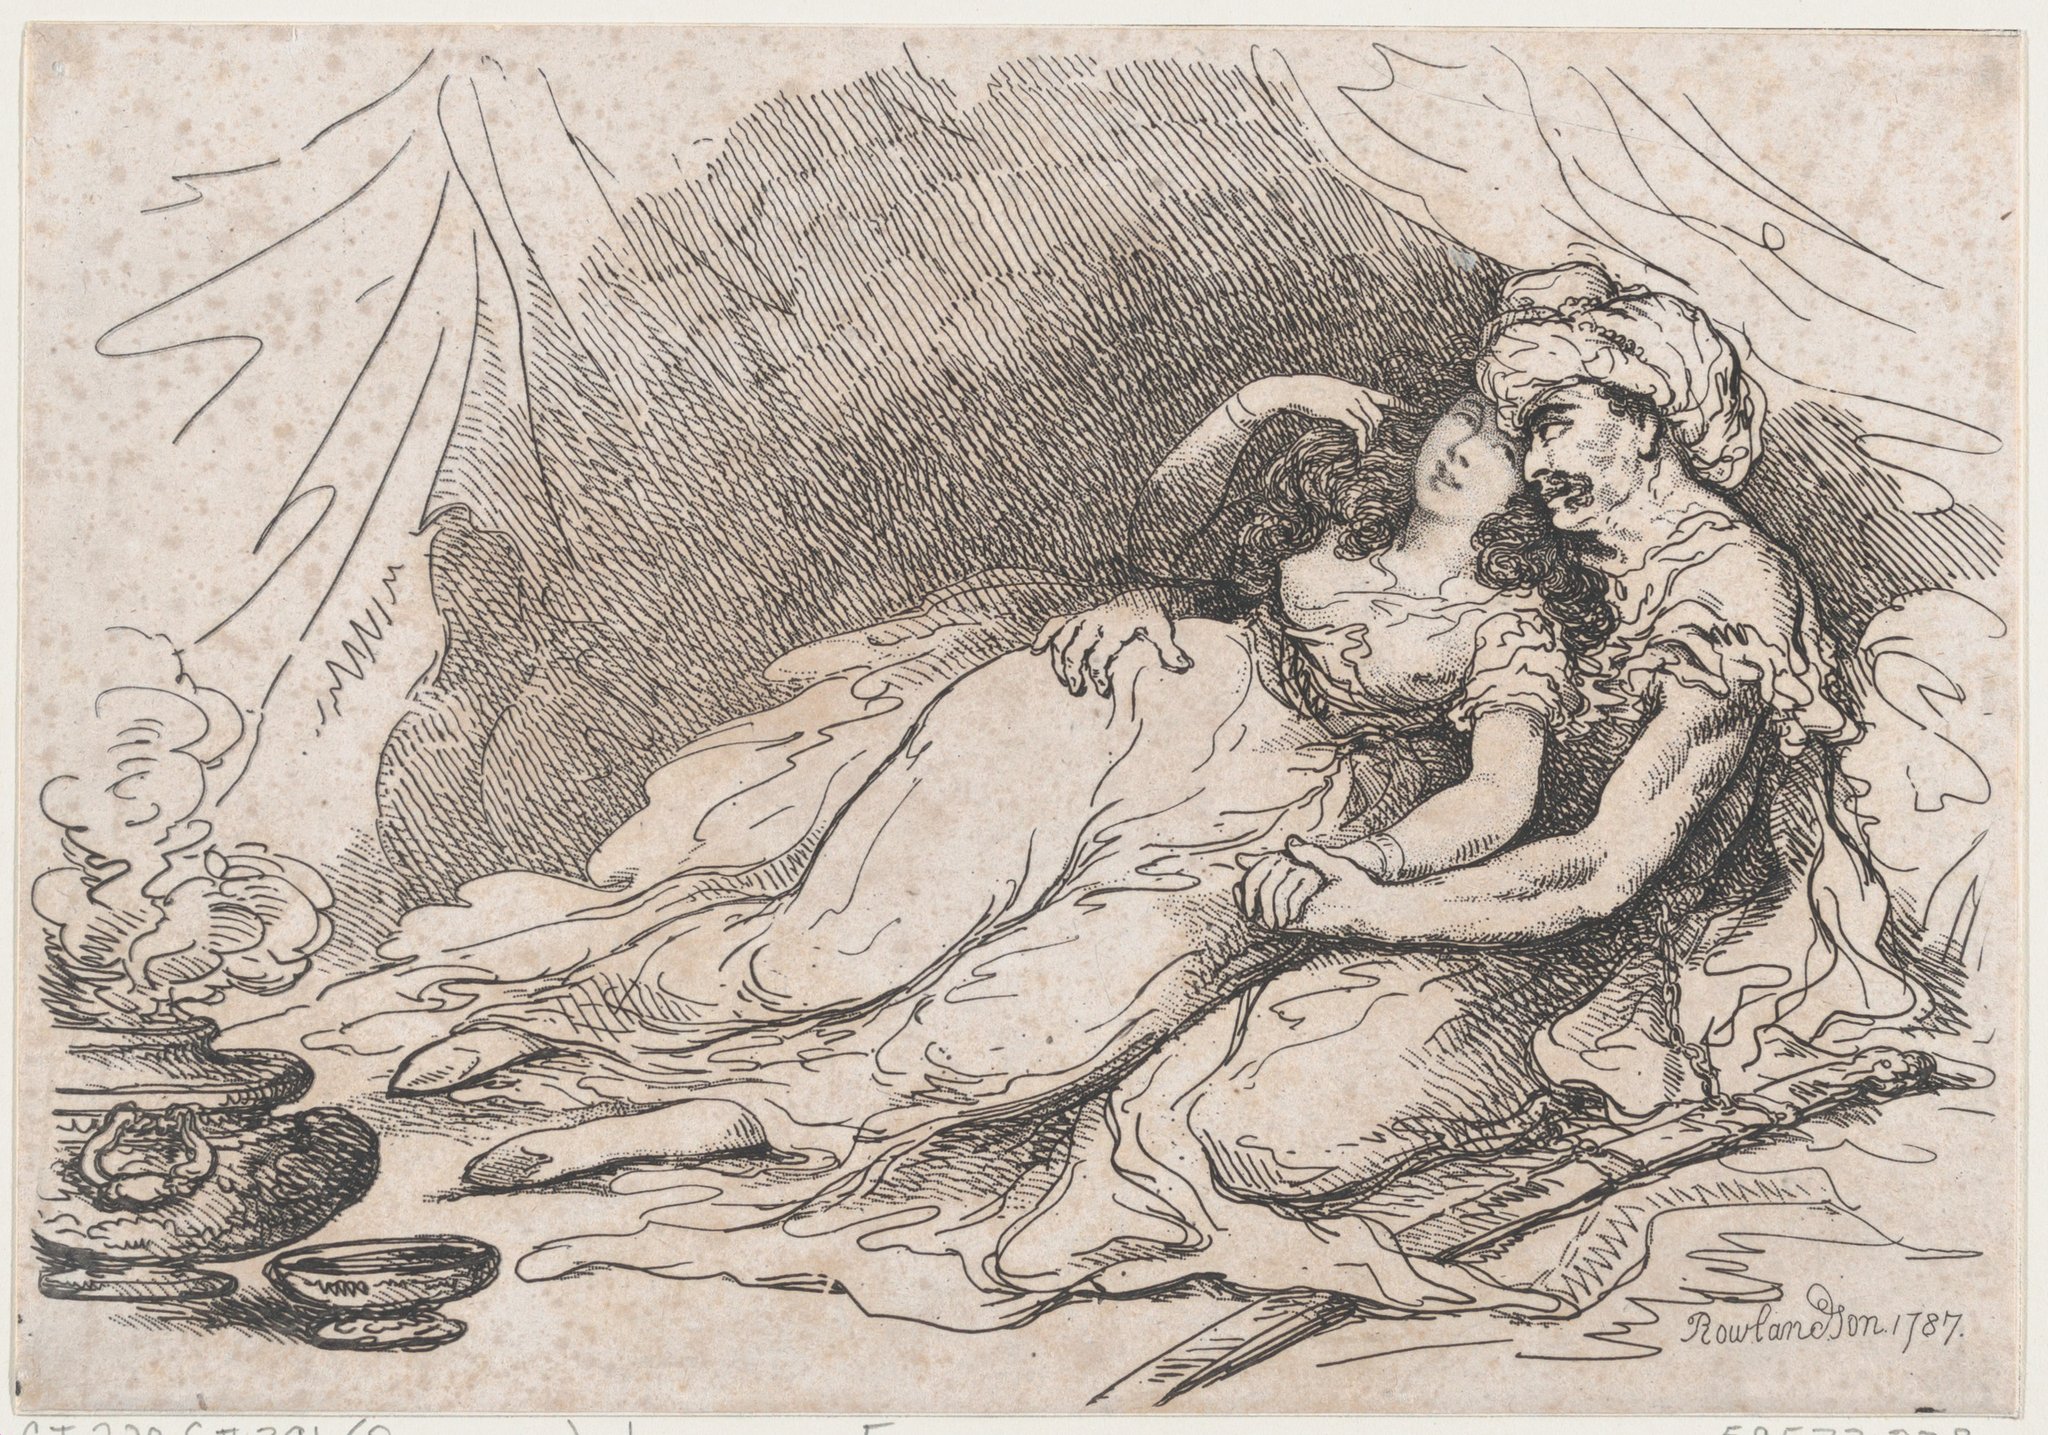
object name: print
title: Love in the East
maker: thomas rowlandson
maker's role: artist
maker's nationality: british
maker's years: 1757-1827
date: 1787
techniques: etching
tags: men,women